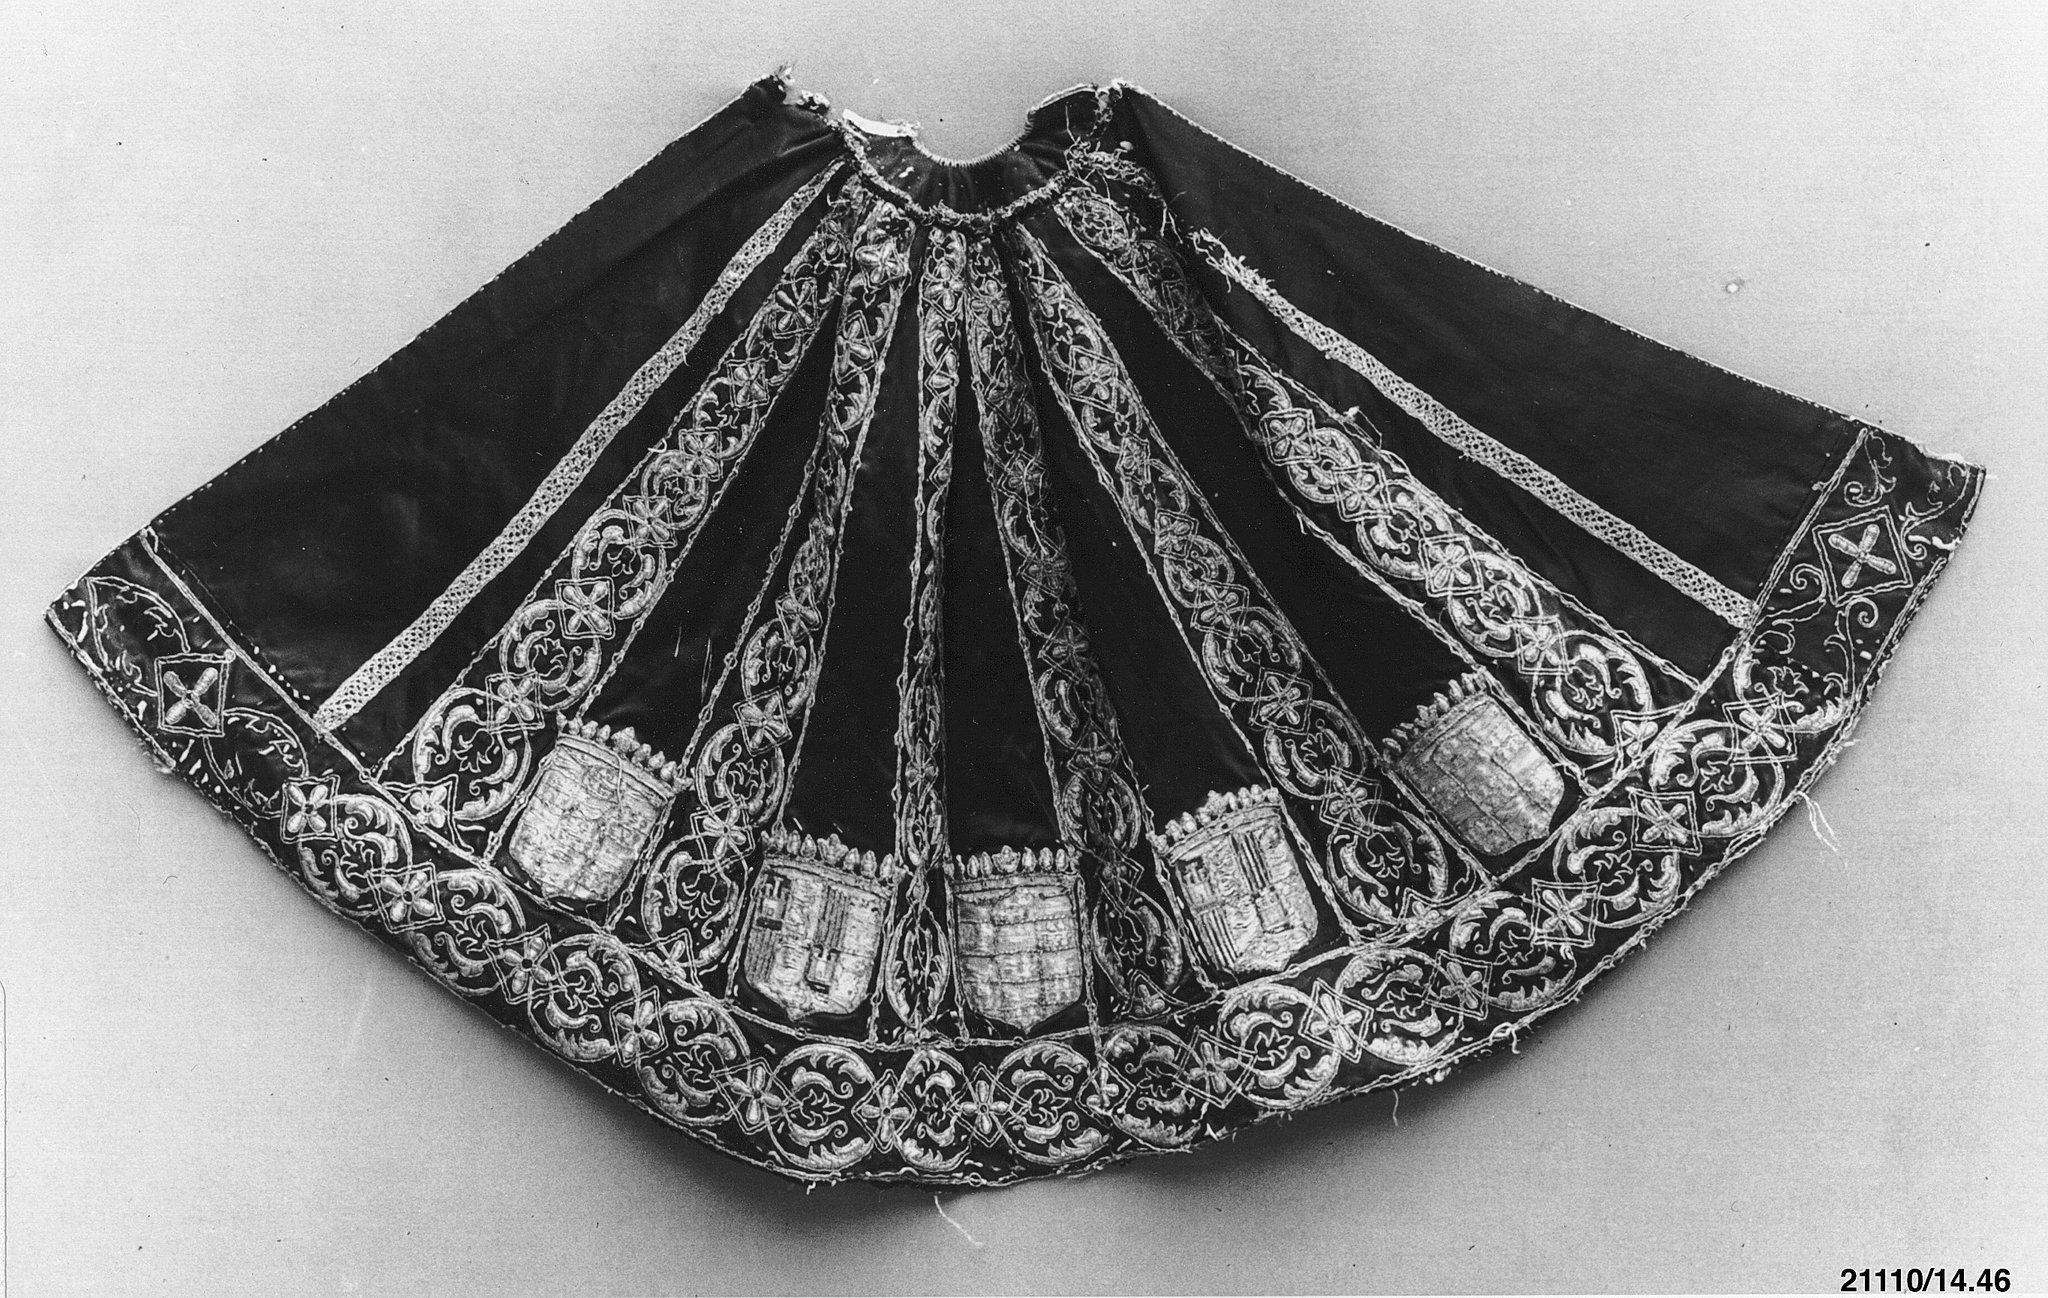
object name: cover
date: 1501-1600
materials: metal thread, silk